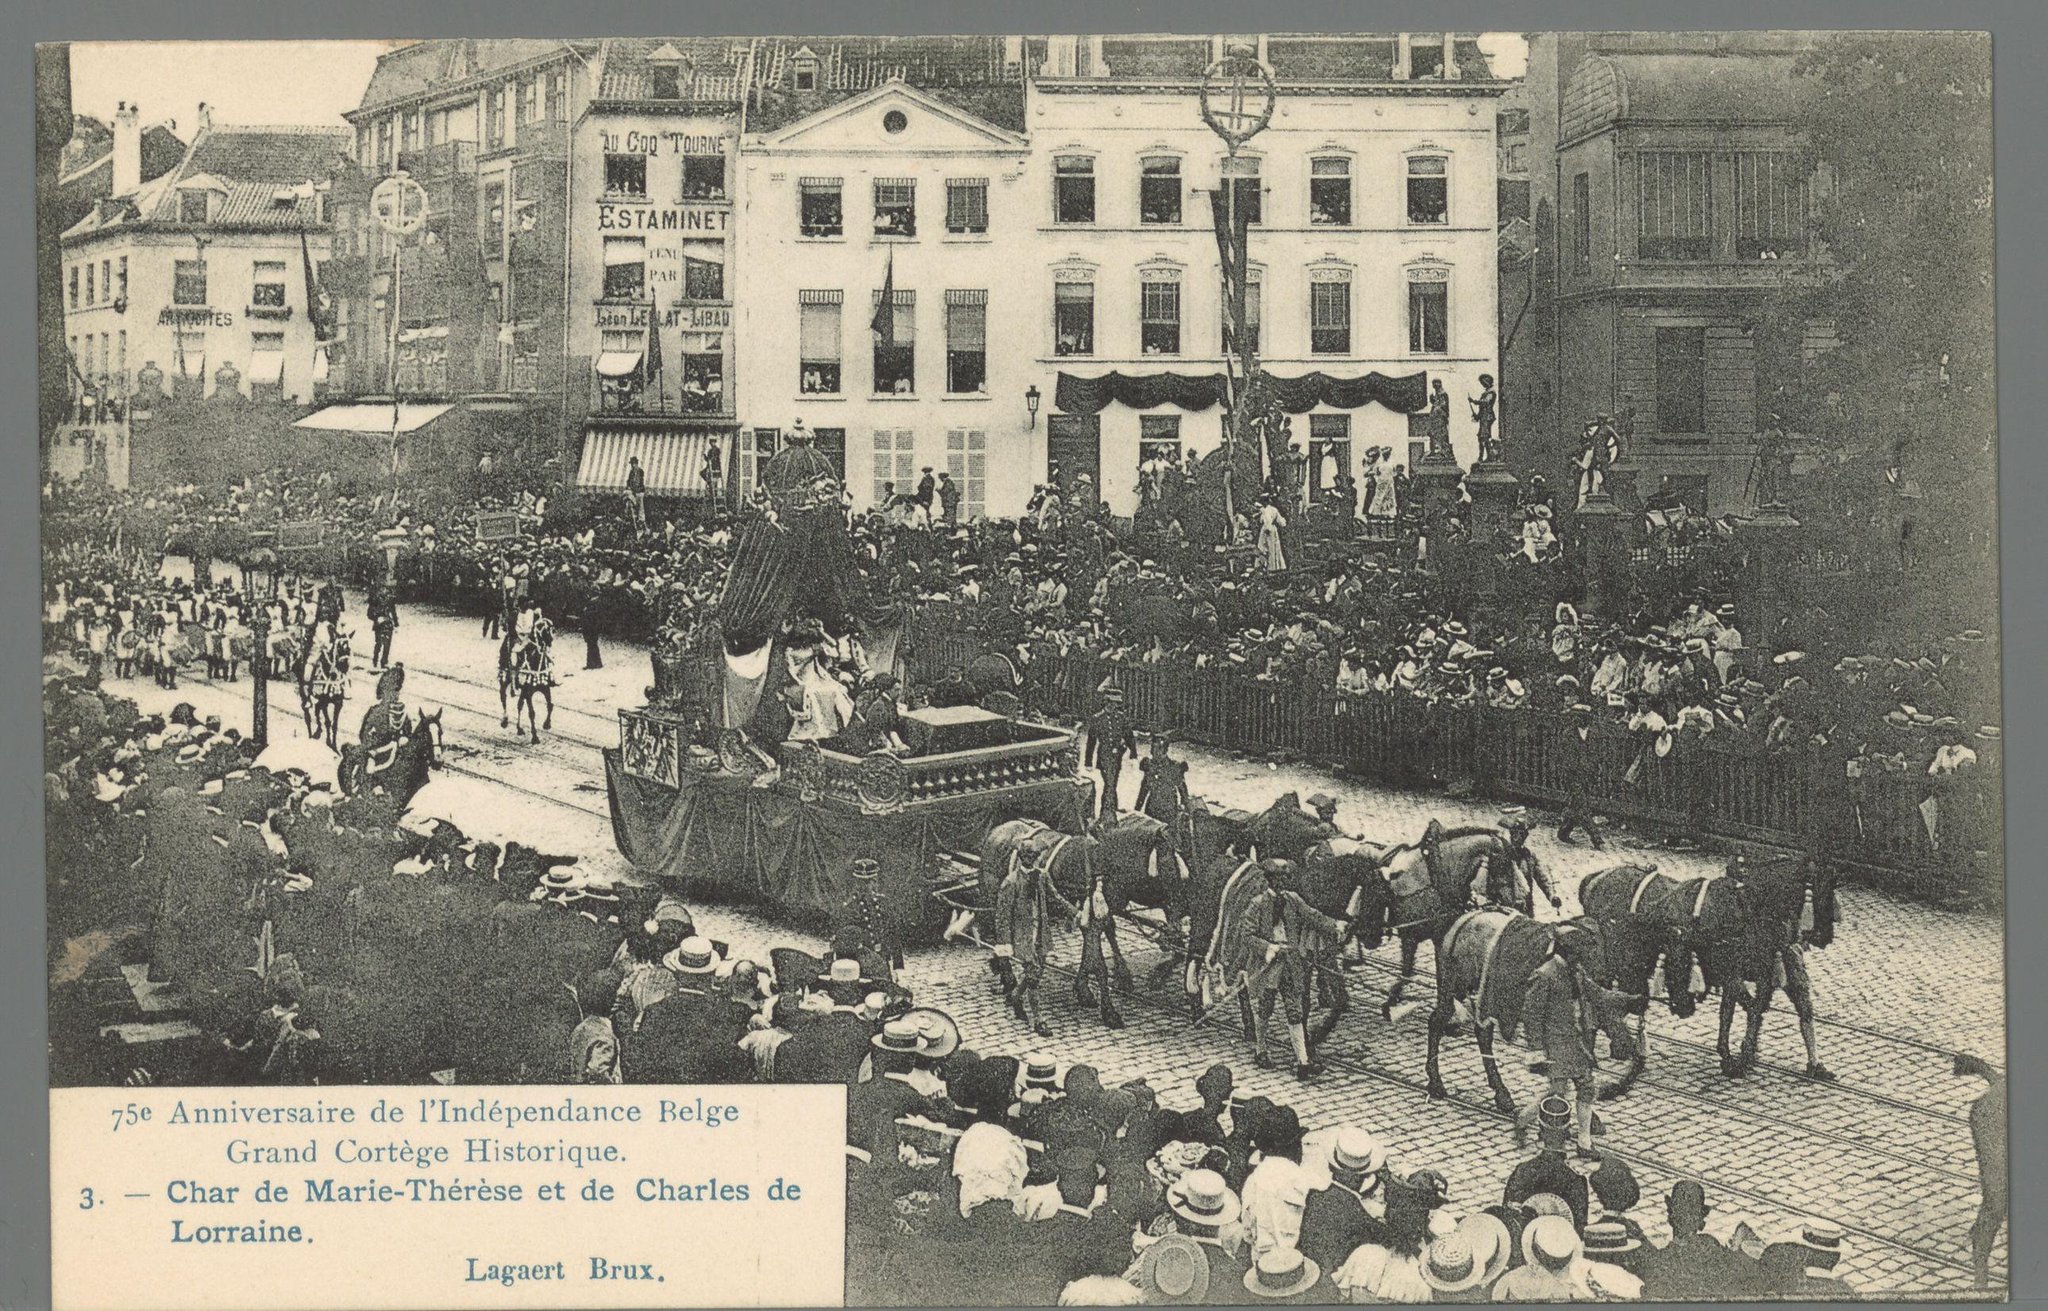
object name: ansichtkaart, prentbriefkaart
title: Char de Marie-Thérèse et de Charles de Lorraine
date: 1905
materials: cardboard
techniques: photograph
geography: schaarbeek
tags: city-view, and landscape with man-made constructions (+ city(-scape) with figures, staffage), periodic celebrations, popular feasts, brussels